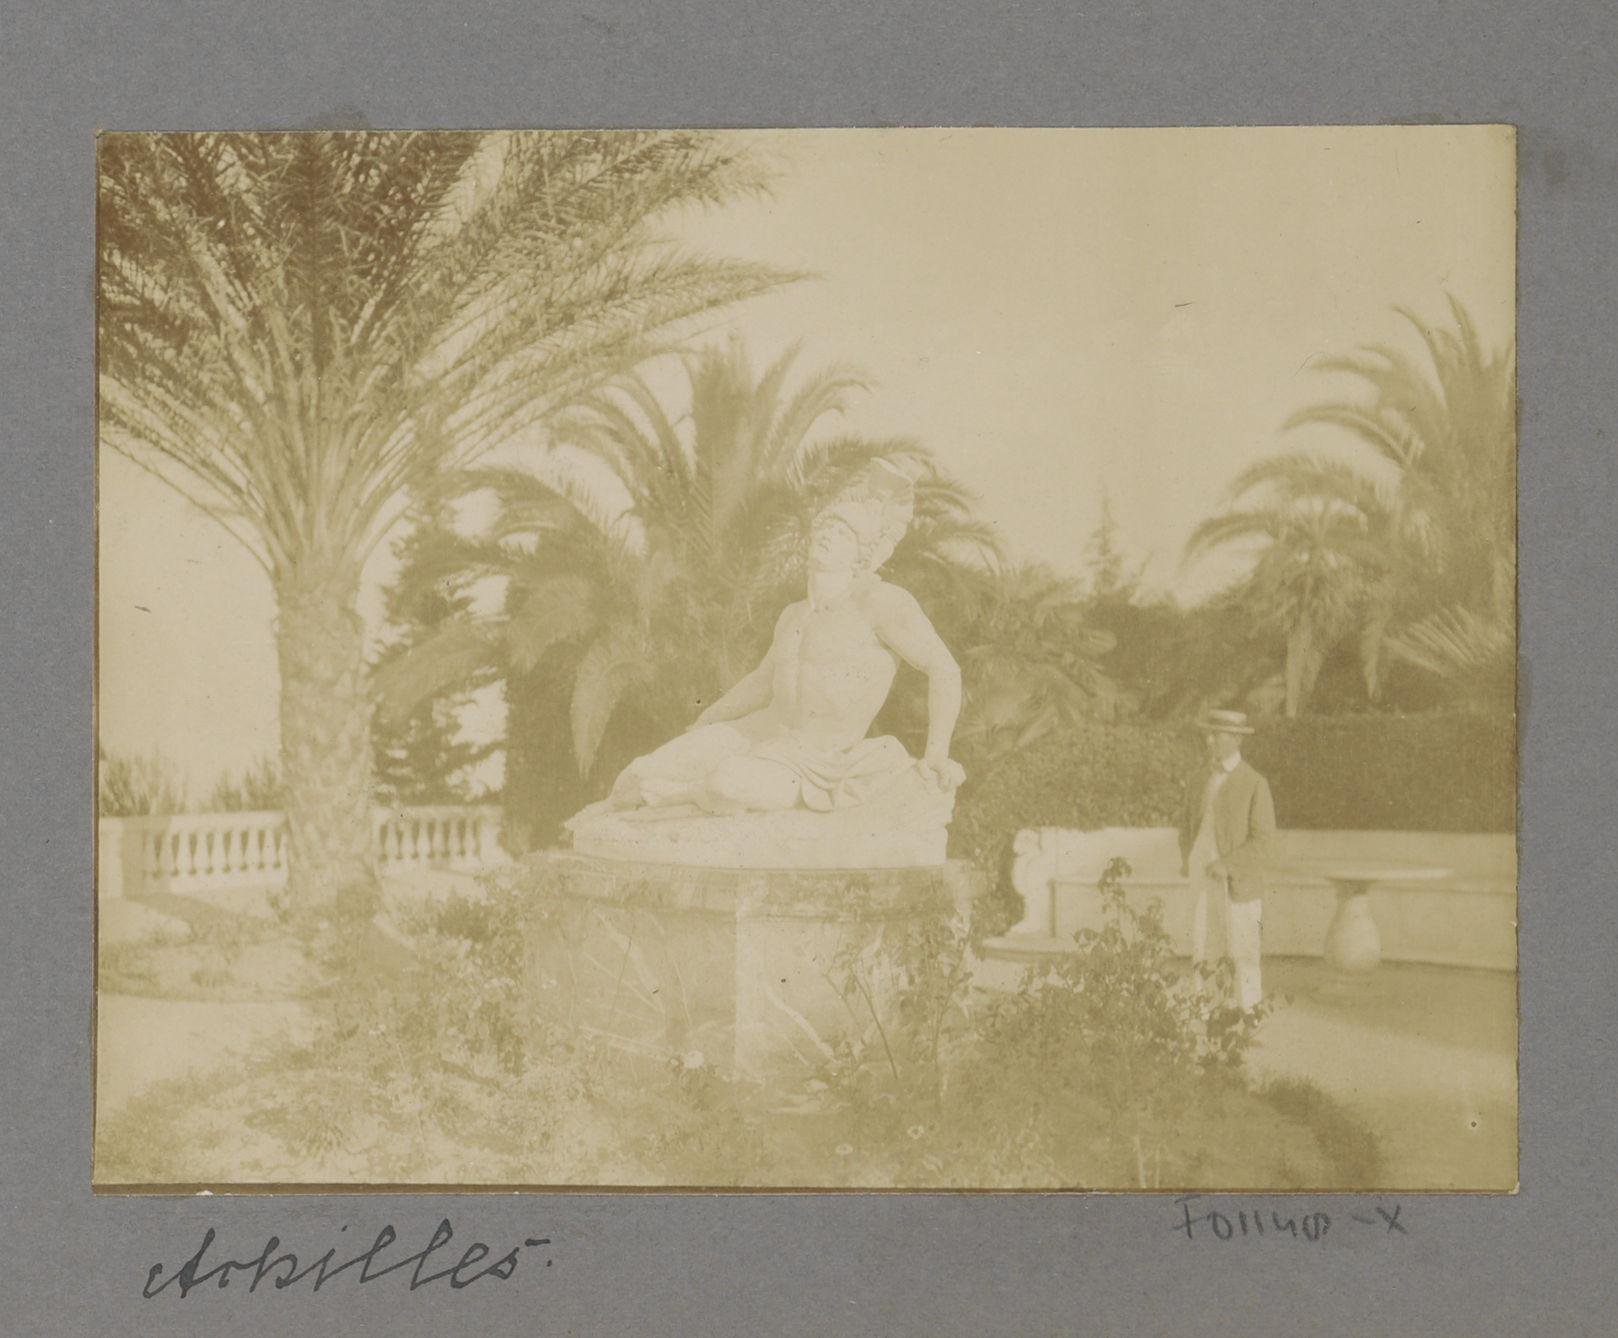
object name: photograph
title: Man staand naast het beeld van Achilles bij het Achilleion op Corfu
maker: Anonymous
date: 1905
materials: paper, photographic support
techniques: gelatin silver print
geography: corfu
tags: piece of sculpture, reproduction of a piece of sculpture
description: Onderdeel van Reisalbum met foto's van bezienswaardigheden in Griekenland en Egypte.